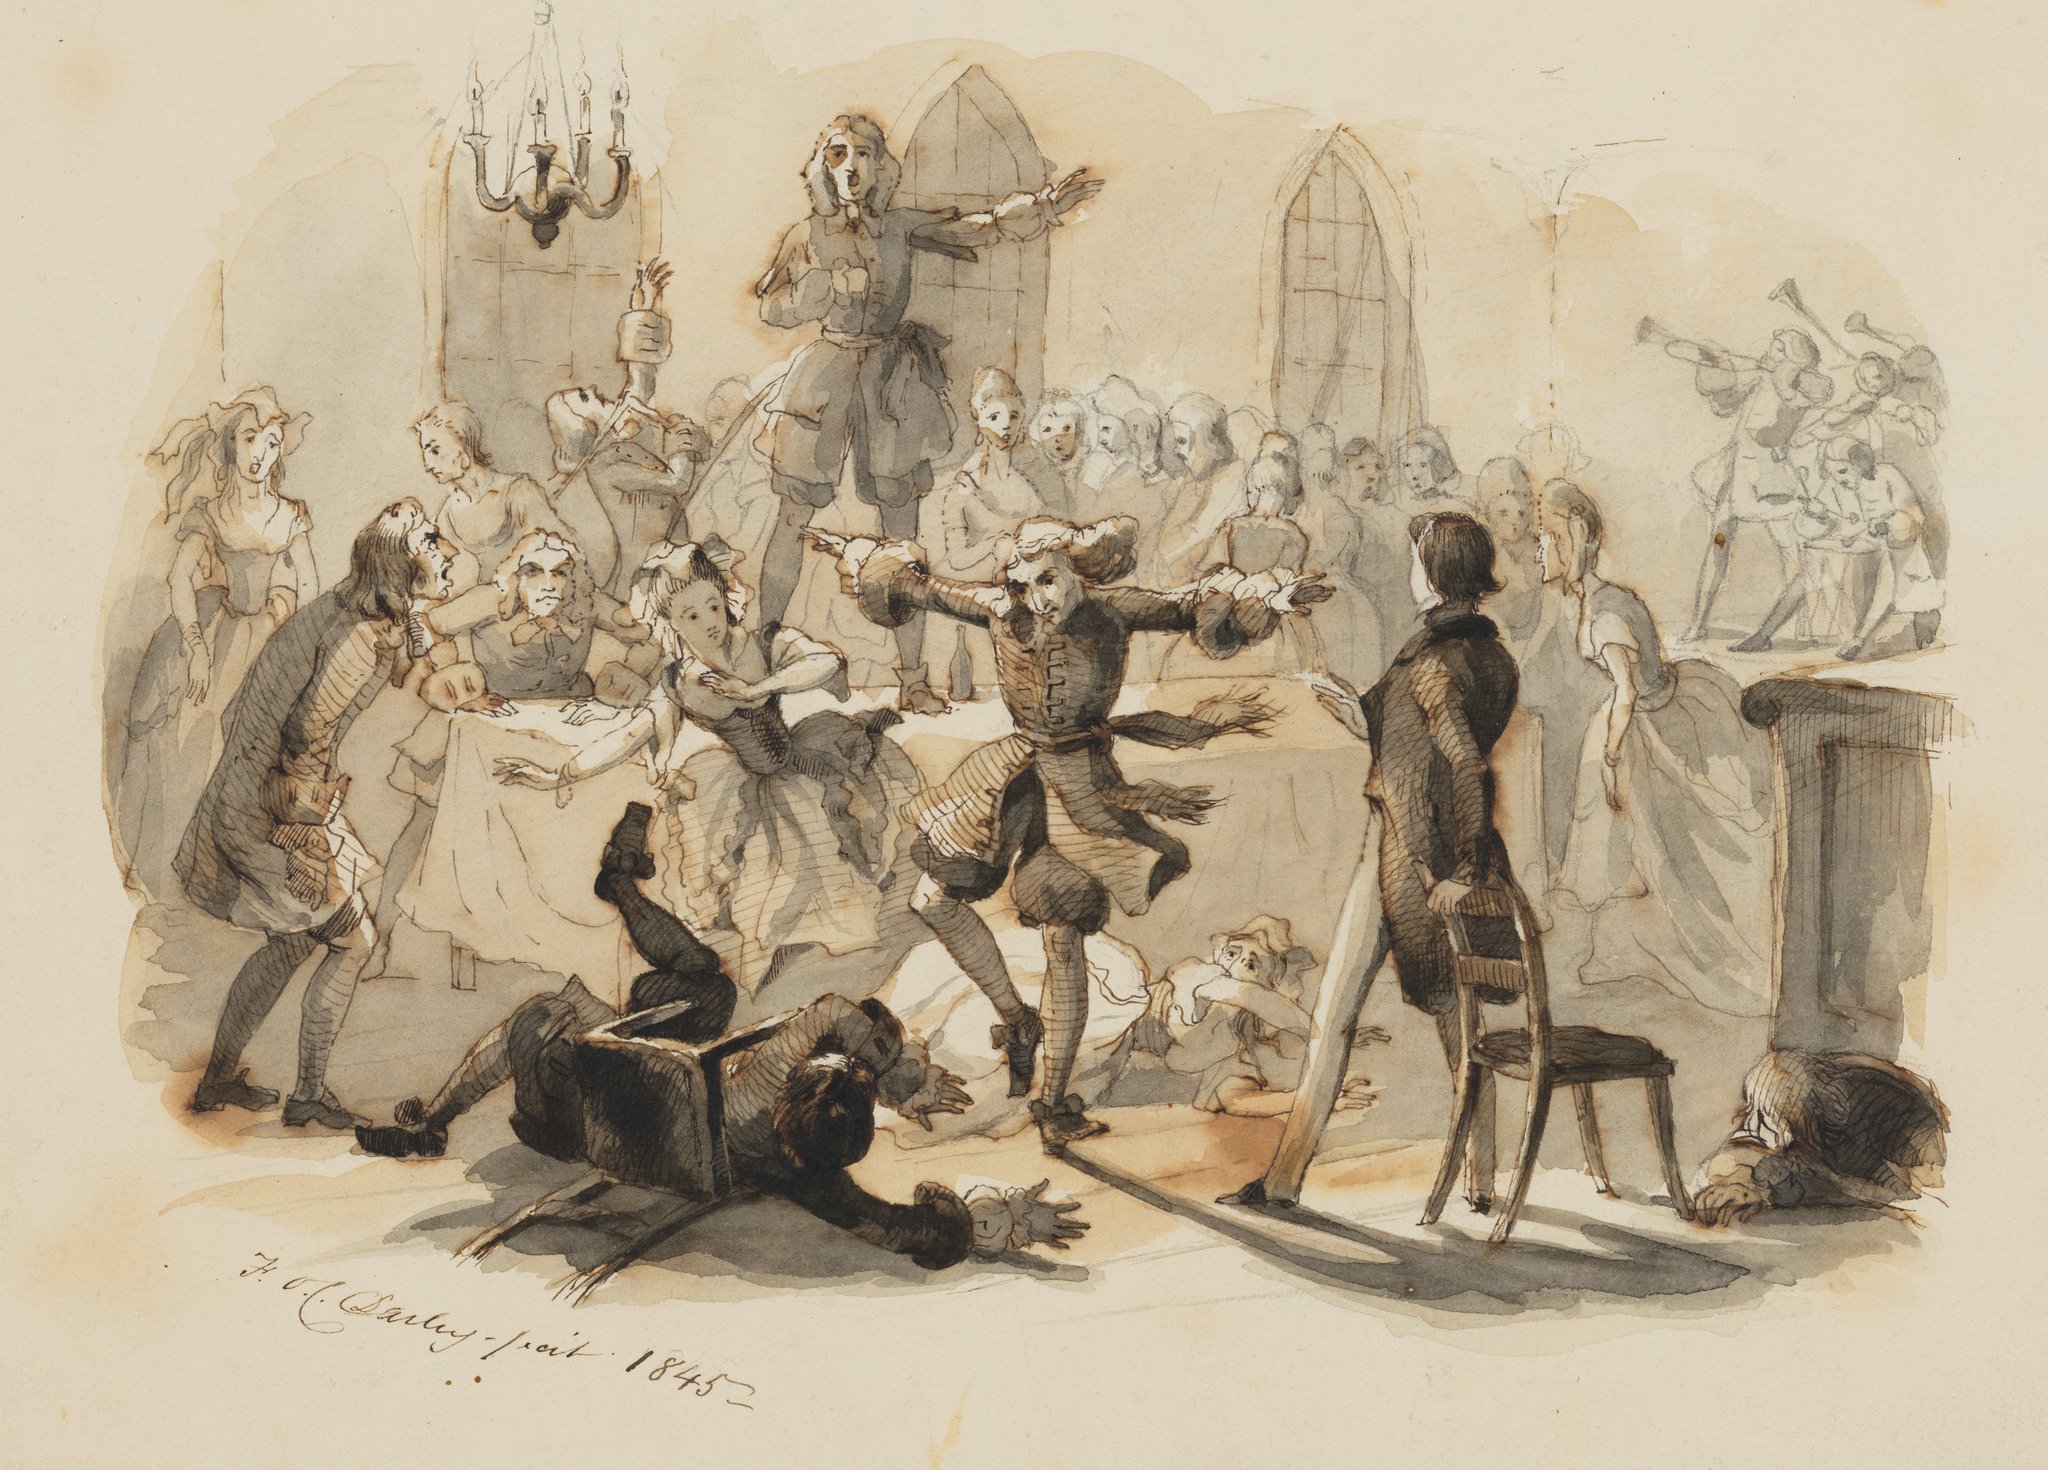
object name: drawing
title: A Rowdy Party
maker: felix octavius carr darley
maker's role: artist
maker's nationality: american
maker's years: 1822-1888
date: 1845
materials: graphite, ink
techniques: brush, pen, wash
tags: men,women,party,dancing,musicians